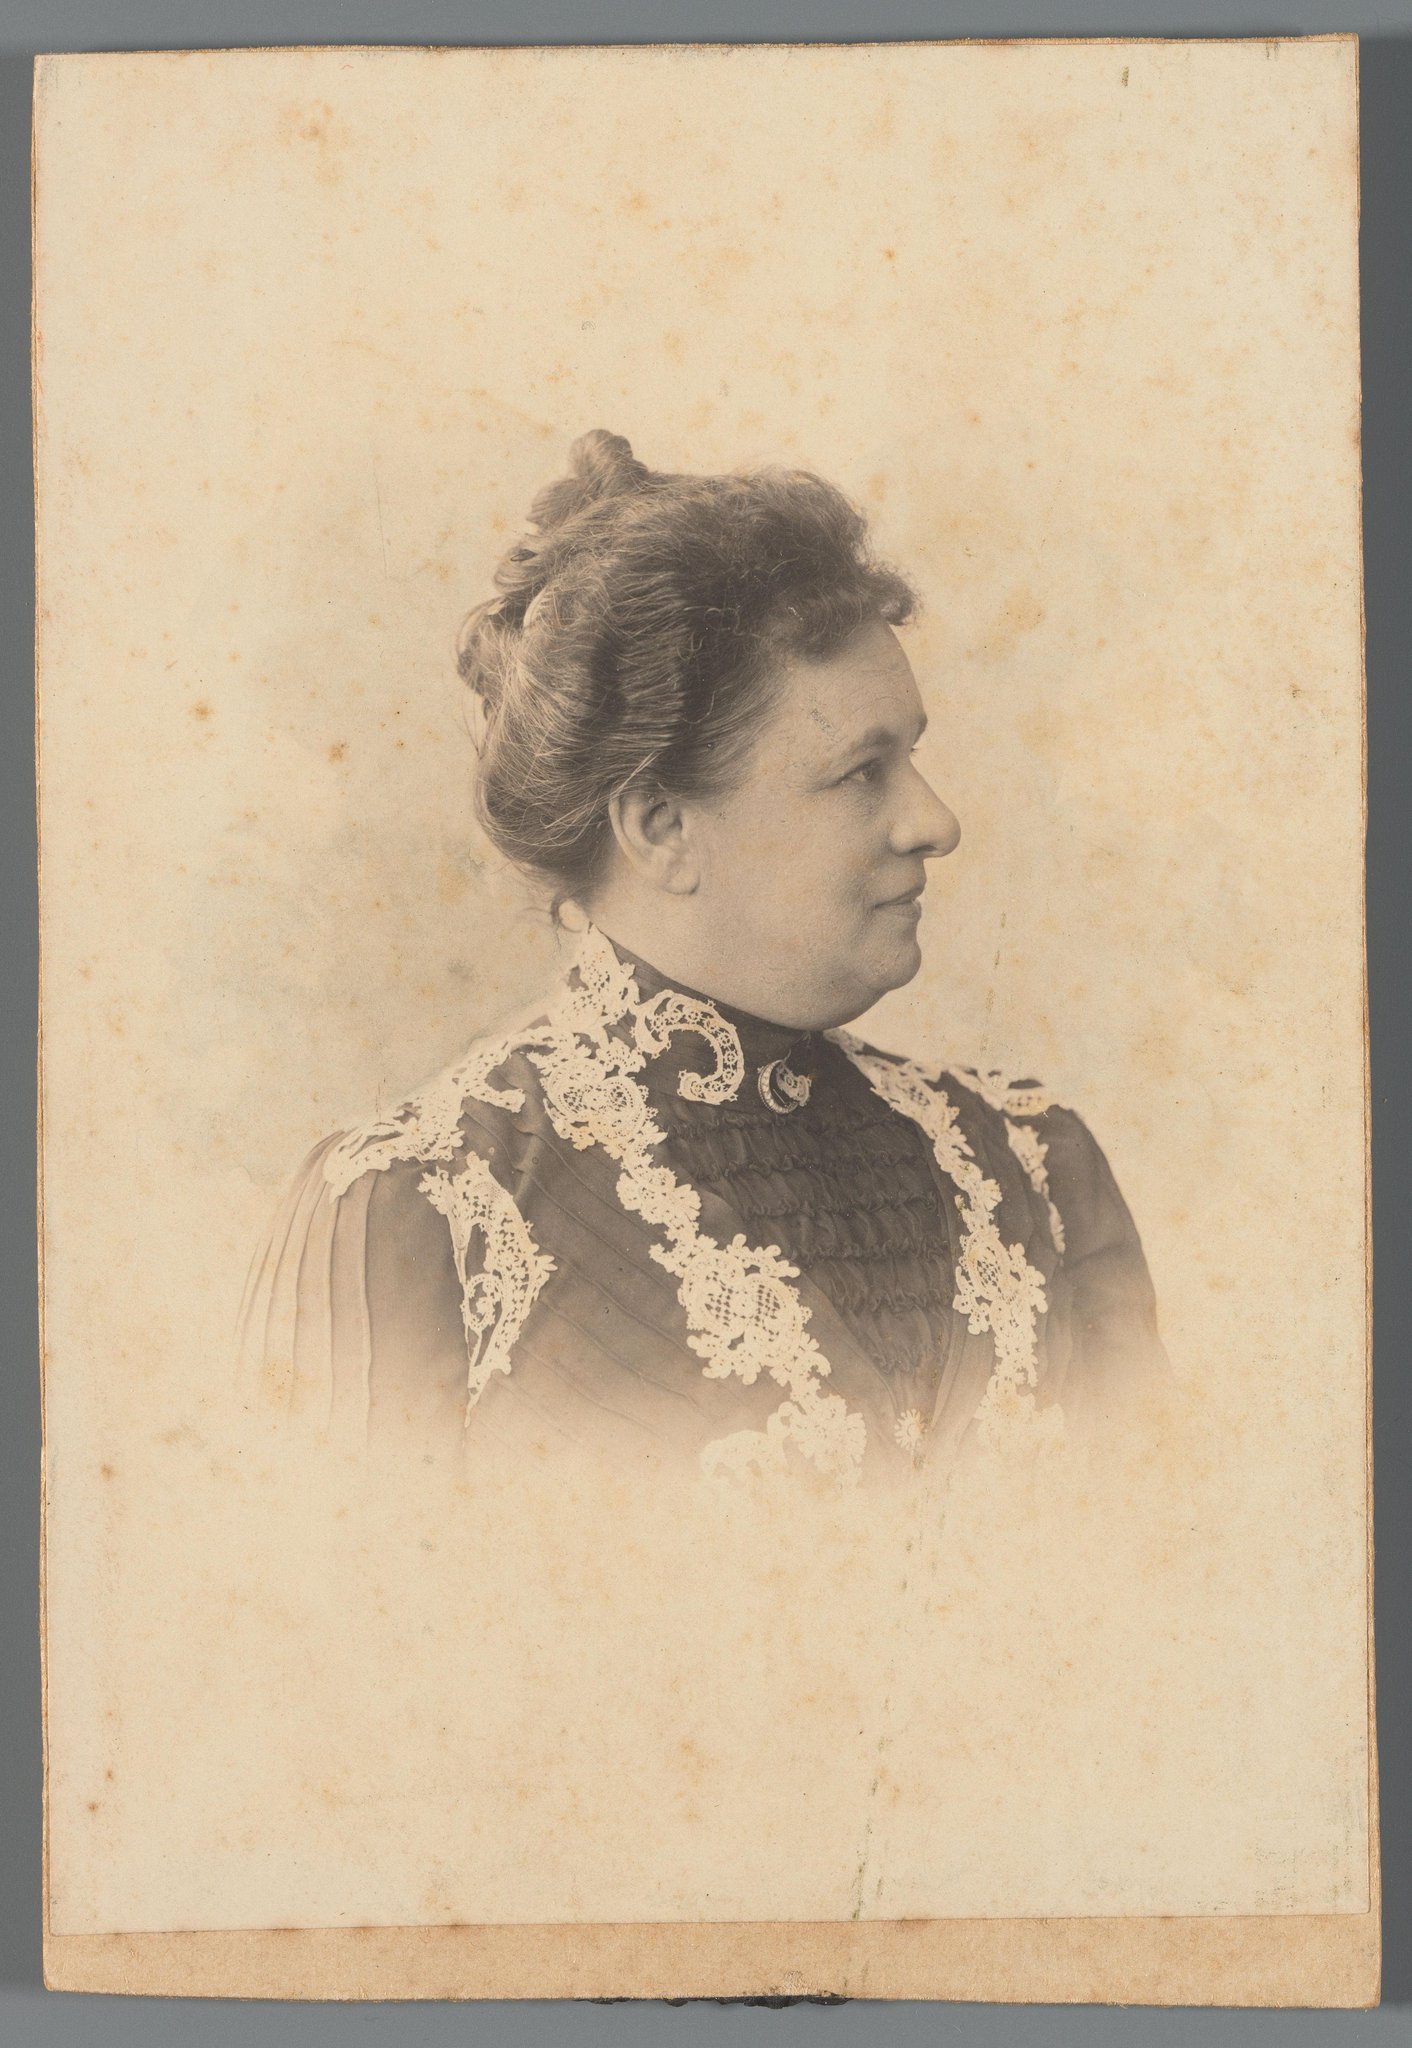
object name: cabinet photograph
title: Studioportret van Françoise van den Berg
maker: Anonymous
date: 1902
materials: cardboard, photographic support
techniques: albumen print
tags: francina schas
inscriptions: inscription: ‘Mama 1902 / 53 / 49 jaar’